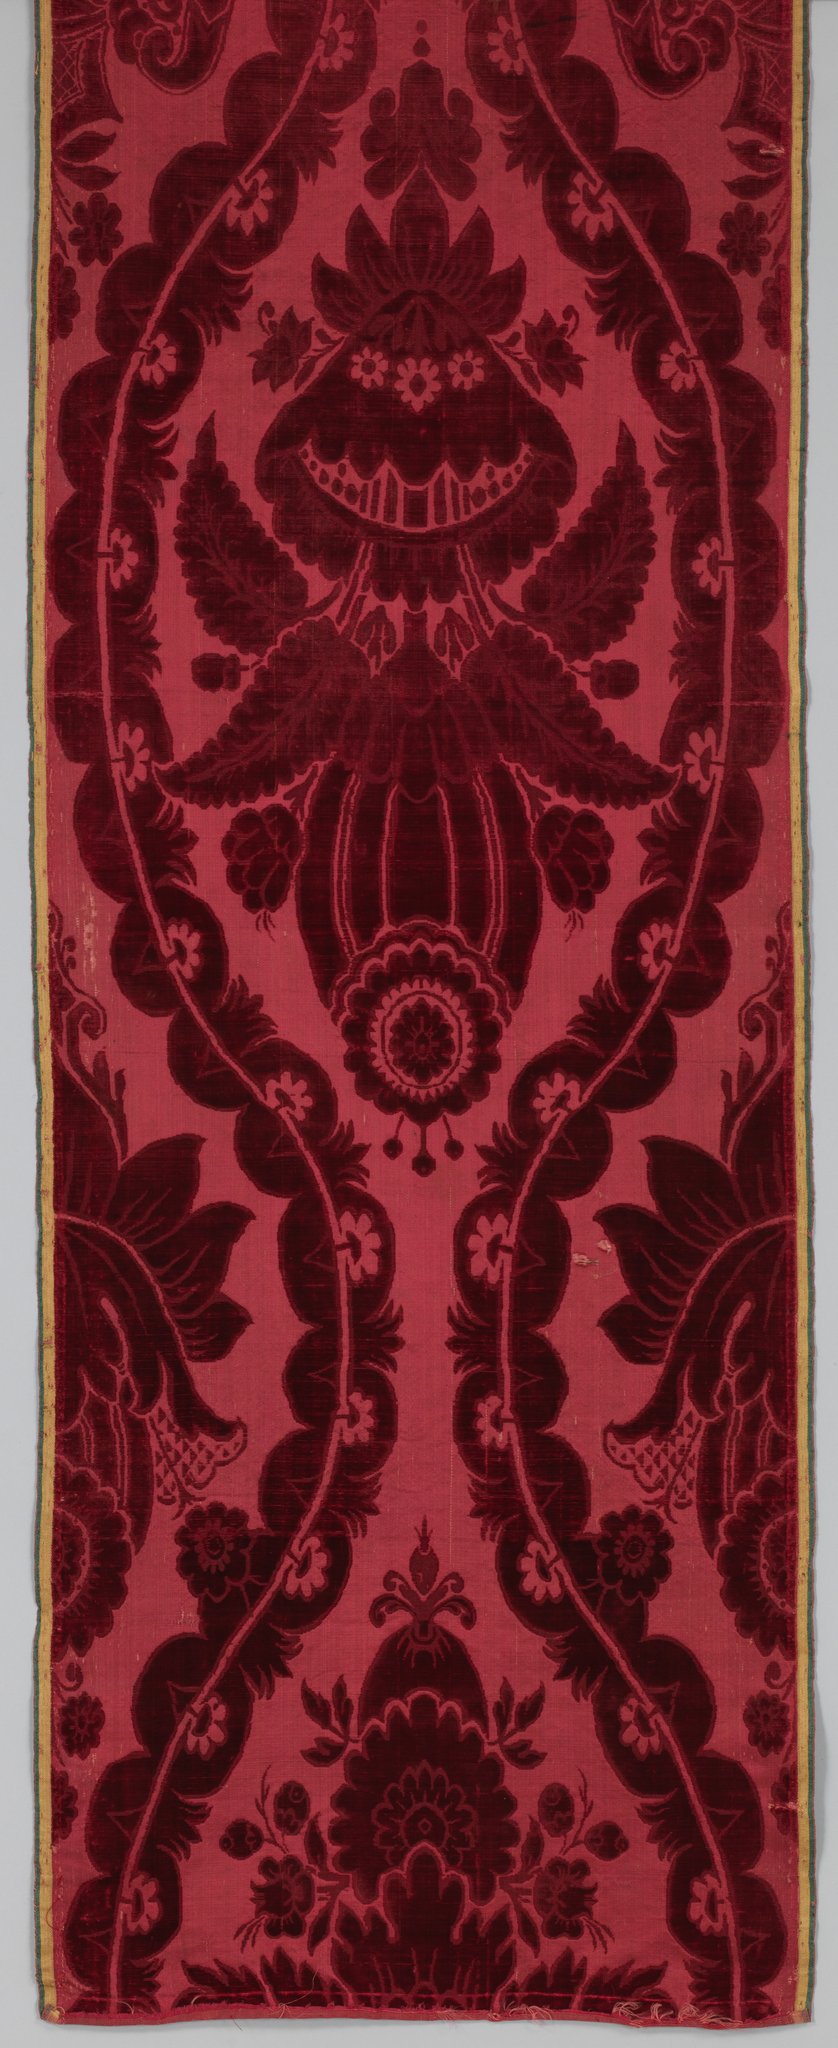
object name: piece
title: Length of velvet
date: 1710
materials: textile, silk, velvet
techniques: cutting, voiding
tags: flowers